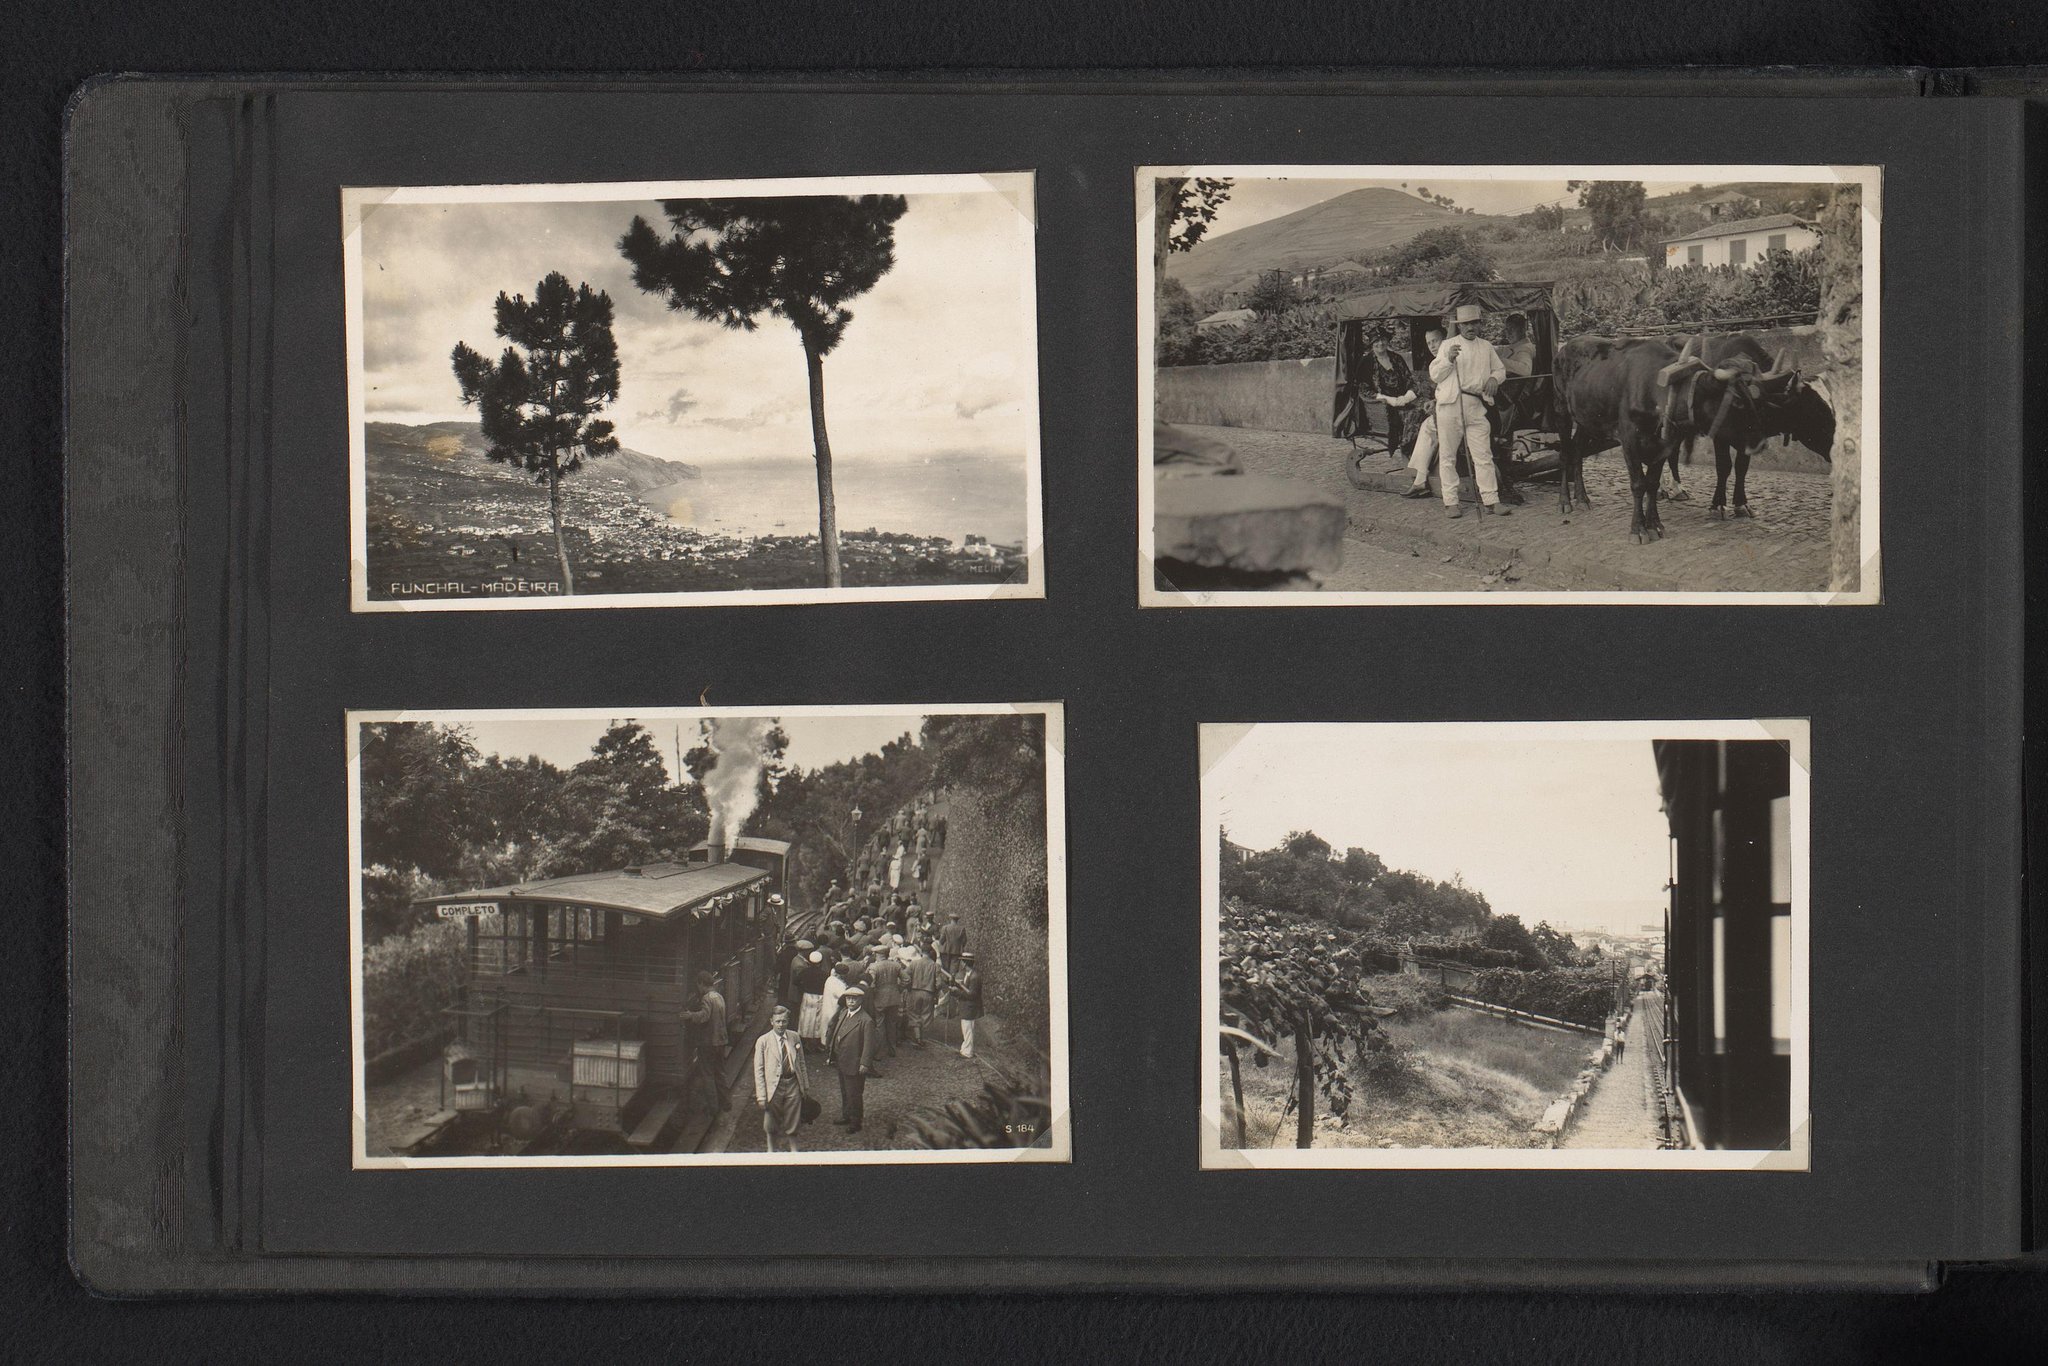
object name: album leaf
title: Vier foto's, waarvan twee prentbriefkaarten, van de familie Van den Berg in Madeira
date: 1933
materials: paper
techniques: gelatin silver print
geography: madeira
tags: batavia, hendrik herman van den berg, the hague, caroline louise van den berg-van den berg, carel frederik van den berg (cay), the family travelling, on holiday, passenger train, city-view in general; 'veduta'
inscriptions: inscription: ‘1/ 2/ 3/4 Trein tusschen Funchal en Monte’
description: Deze foto's maken deel uit van een album.